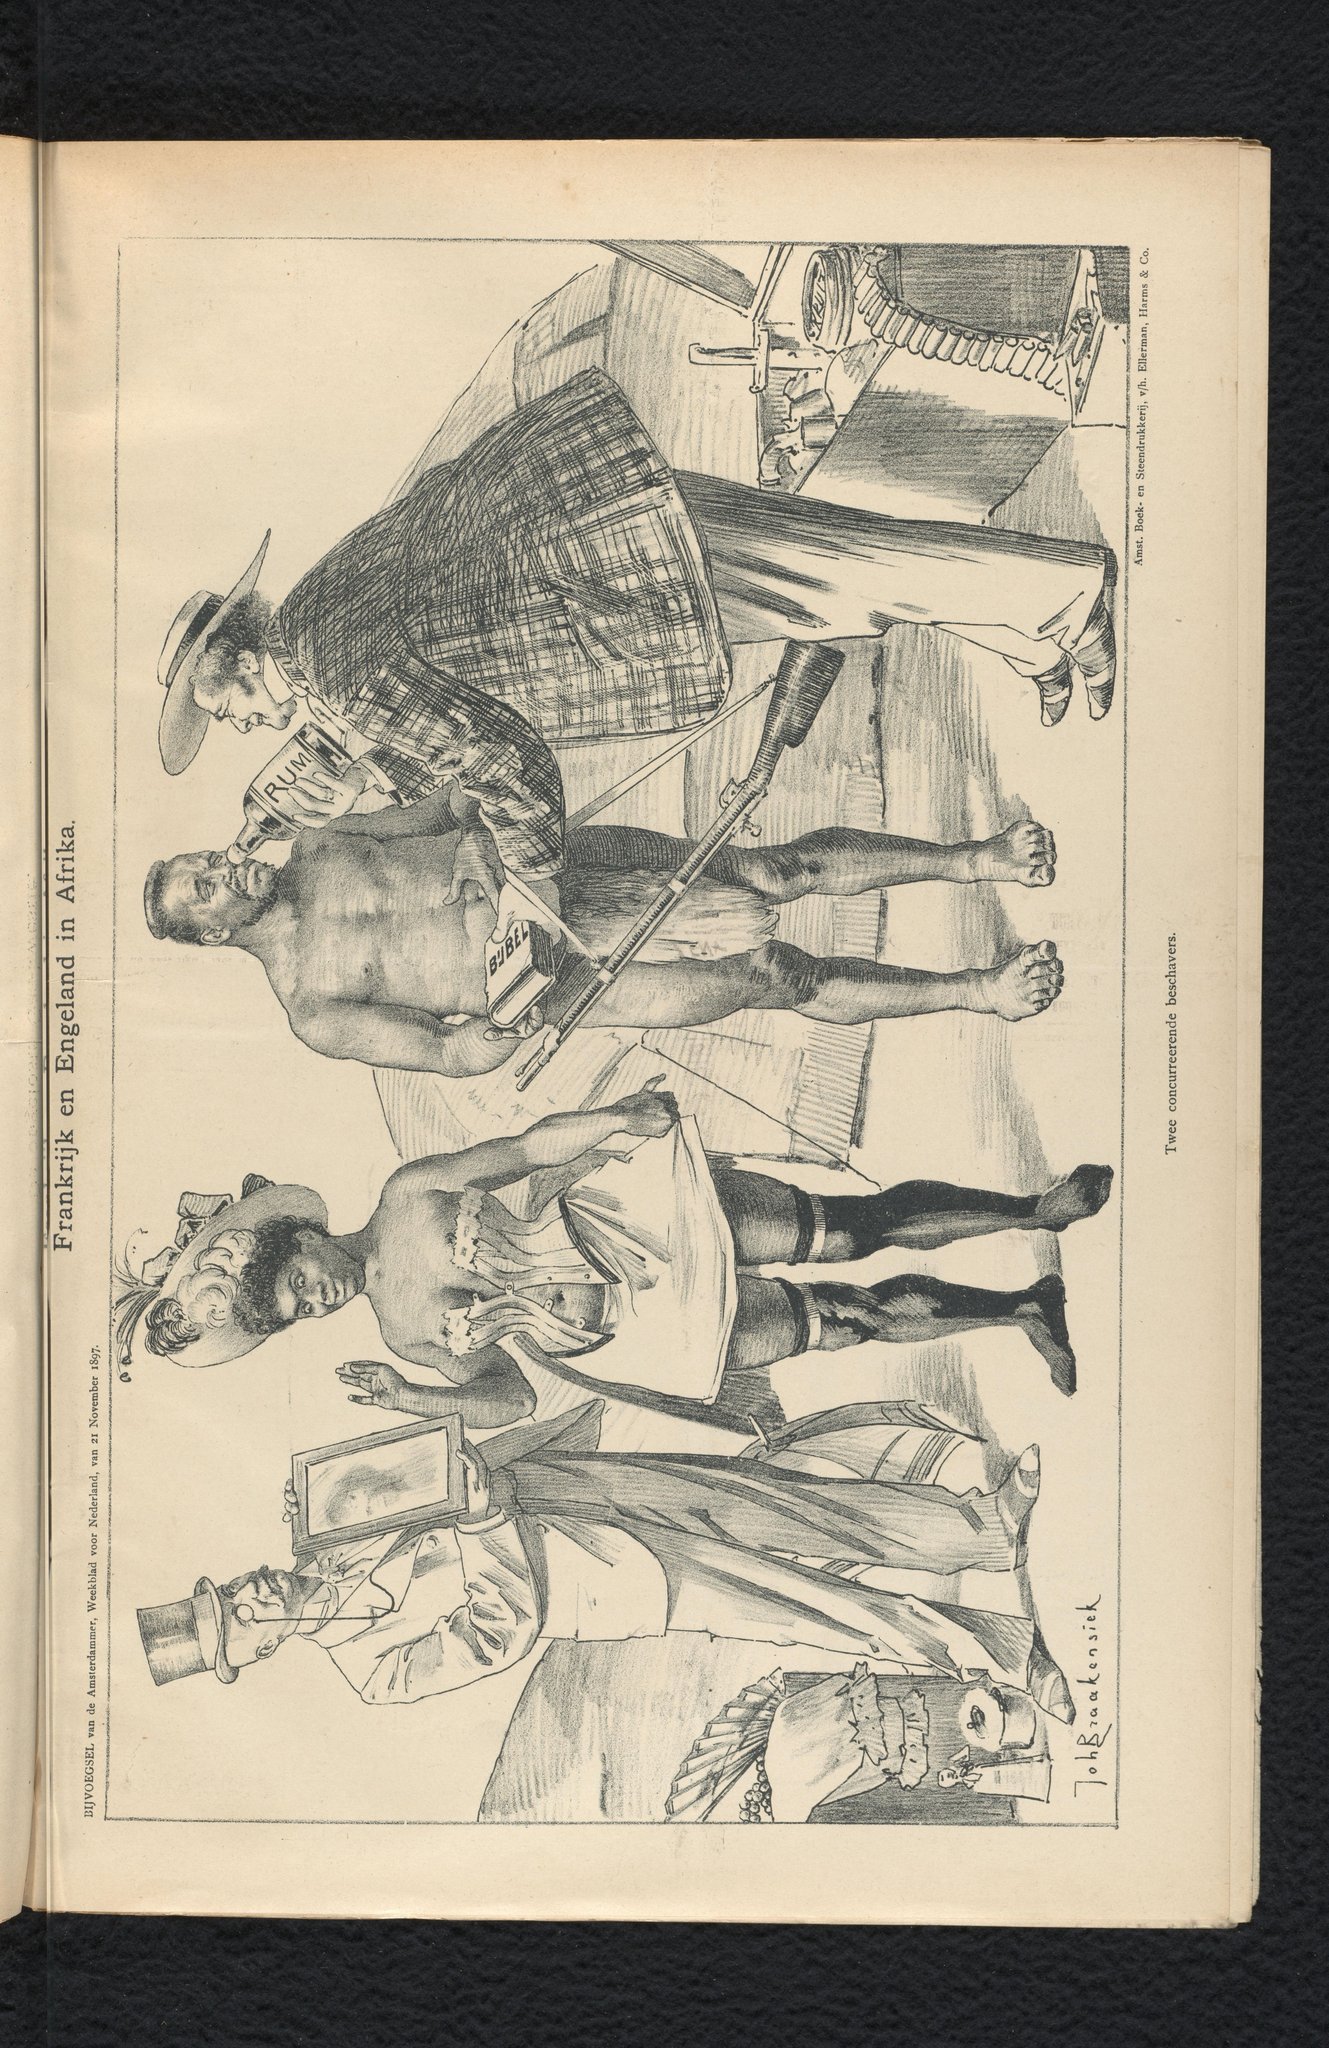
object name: cartoon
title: Frankrijk en Engeland in Afrika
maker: johan braakensiek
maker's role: draughtsman, print maker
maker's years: 1858-1940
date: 1897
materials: paper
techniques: lithograph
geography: netherlands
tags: personifications of countries, nations, states, districts, etc., africans, looking in the mirror; contemplation of own beauty, stockings, socks, alcoholic drinks, firearms, underclothes for the upper part of the body: corset, the bible as a book, political caricatures and satires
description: Vertegenwoordigers van Frankrijk en Engeland proberen hun waar te slijten aan een Afrikaanse man en vrouw. De vrouw krijgt van Frankrijk ondergoed en een hoed, de man van Engeland drank, wapens en de Bijbel.